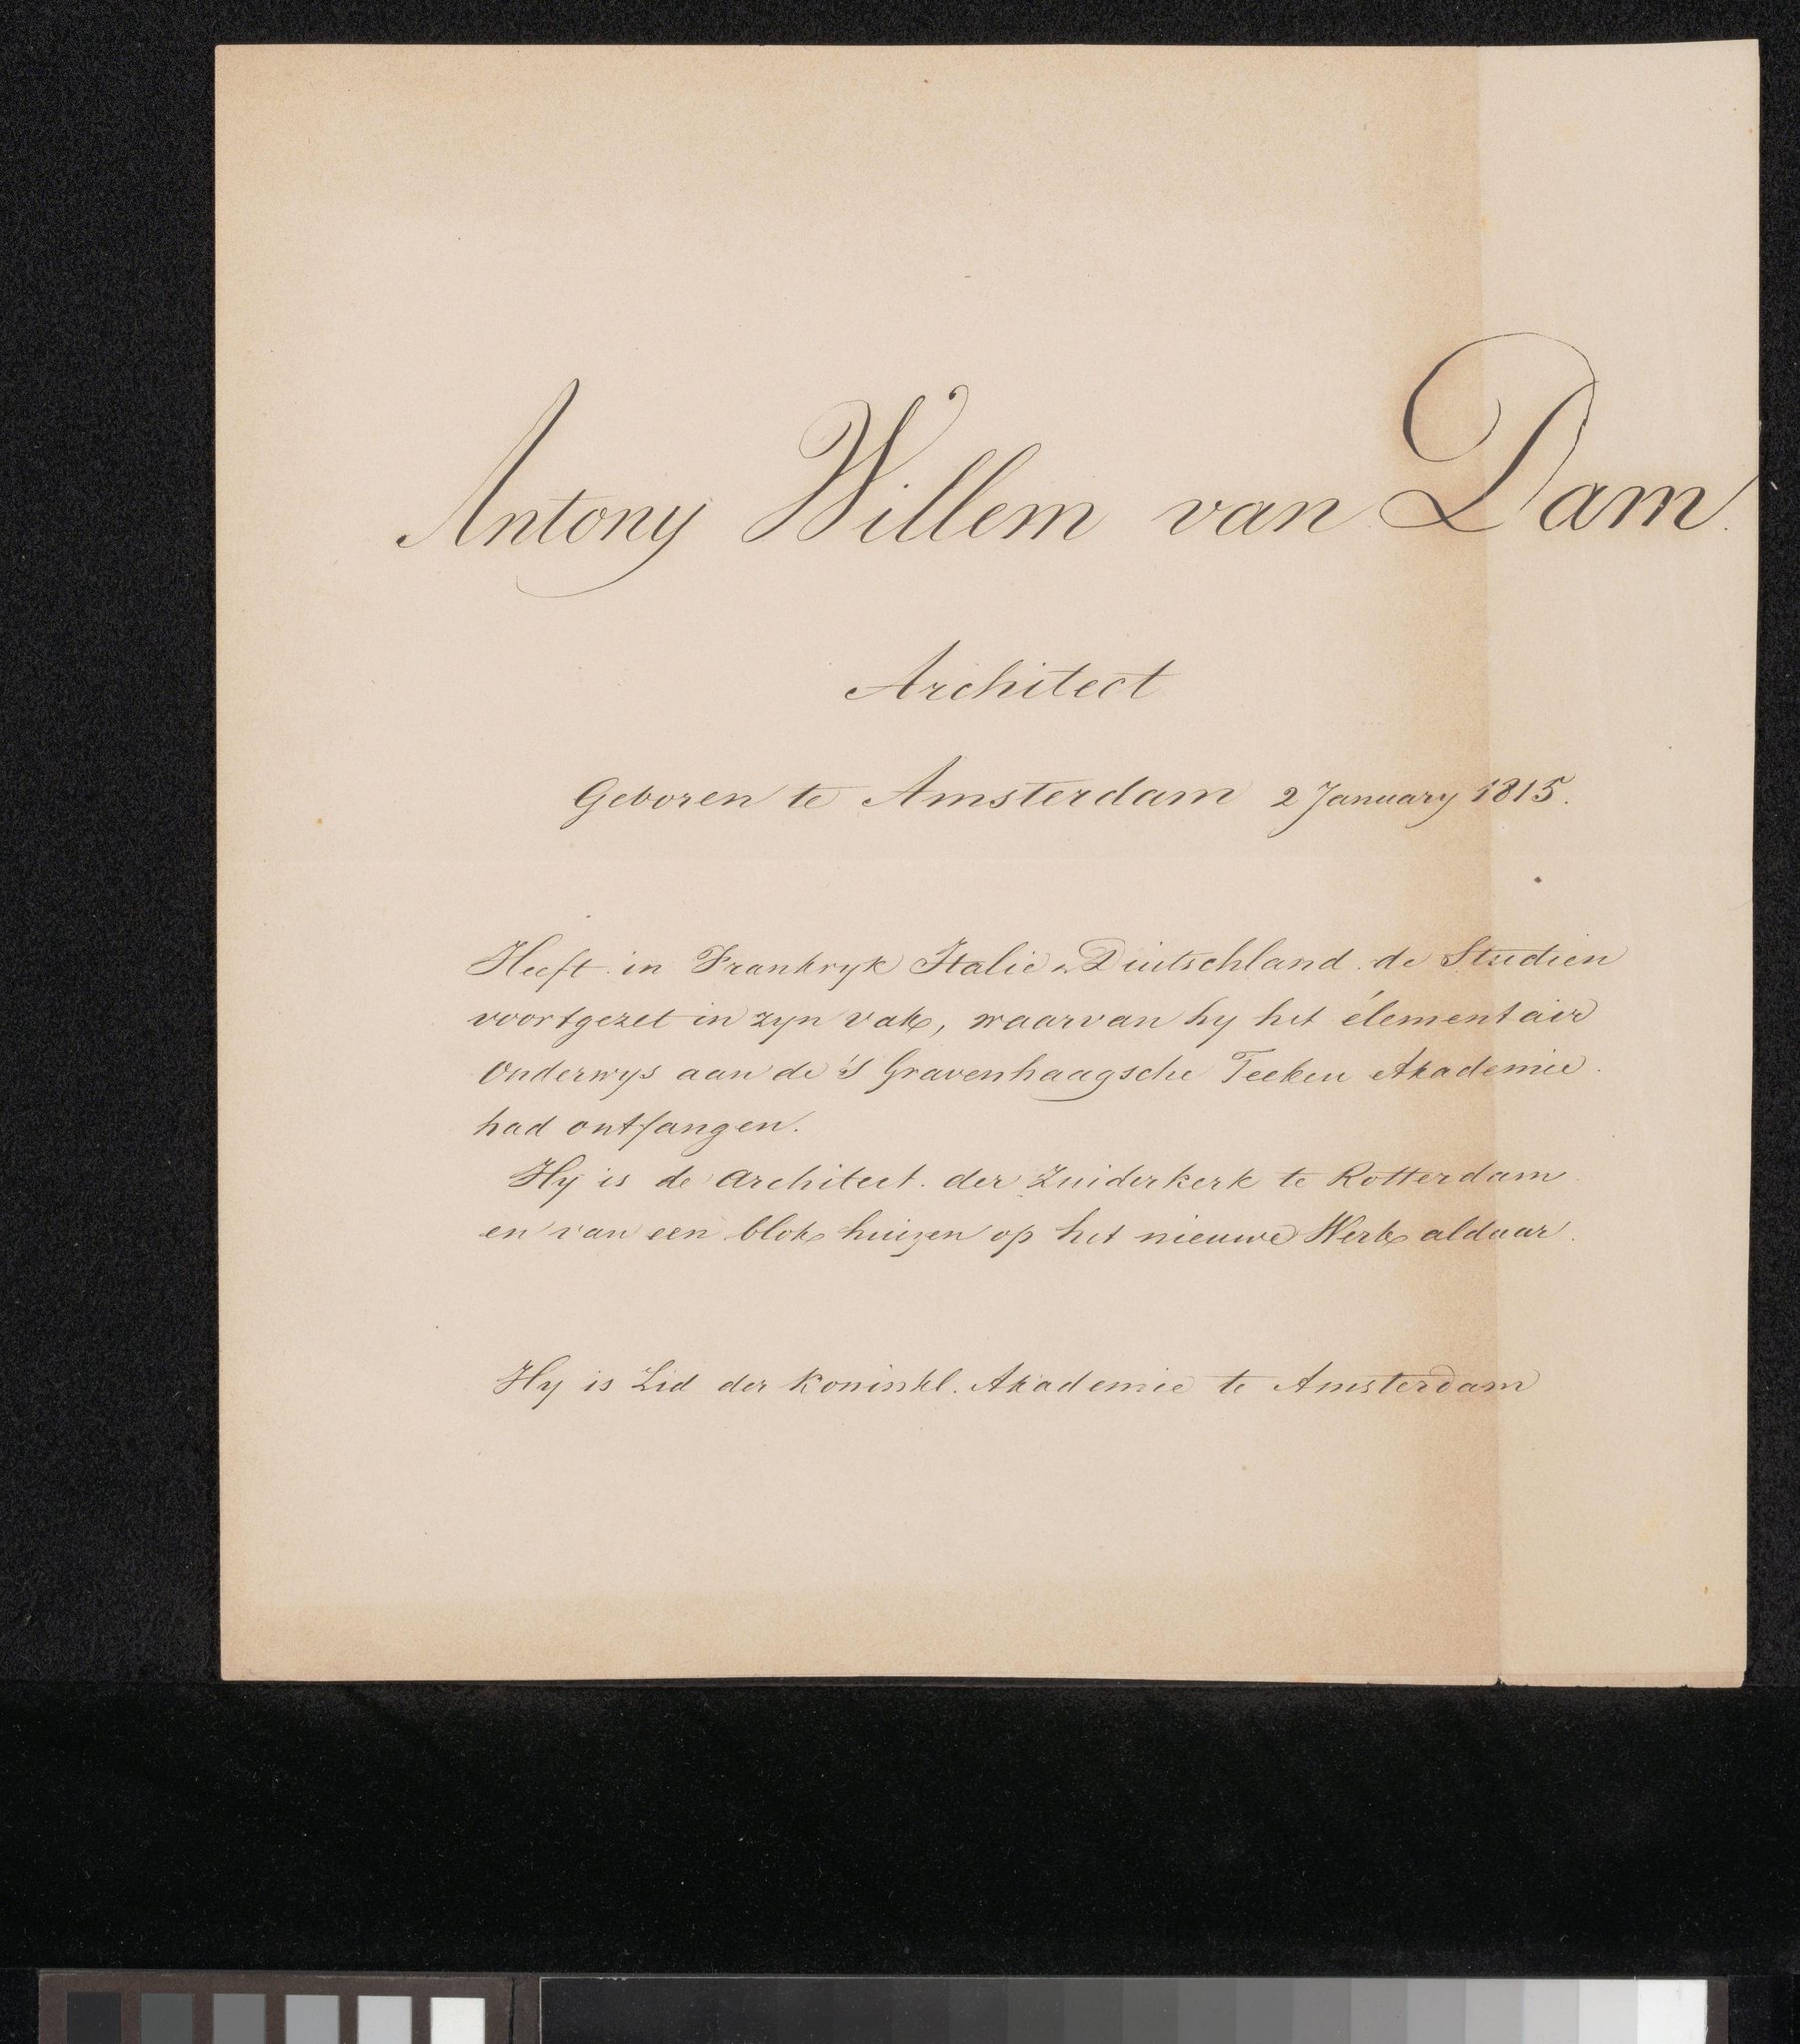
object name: tekst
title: Tekst betreffende Anthony Willem van Dam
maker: Anonymous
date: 1844-1901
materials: ink, paper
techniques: pen, writing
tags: the hague, draughtsman, anthony willem van dam, education, tuition of the artist (in general), architecture, italy, germany, rotterdam, france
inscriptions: collector's mark: ‘RPK’